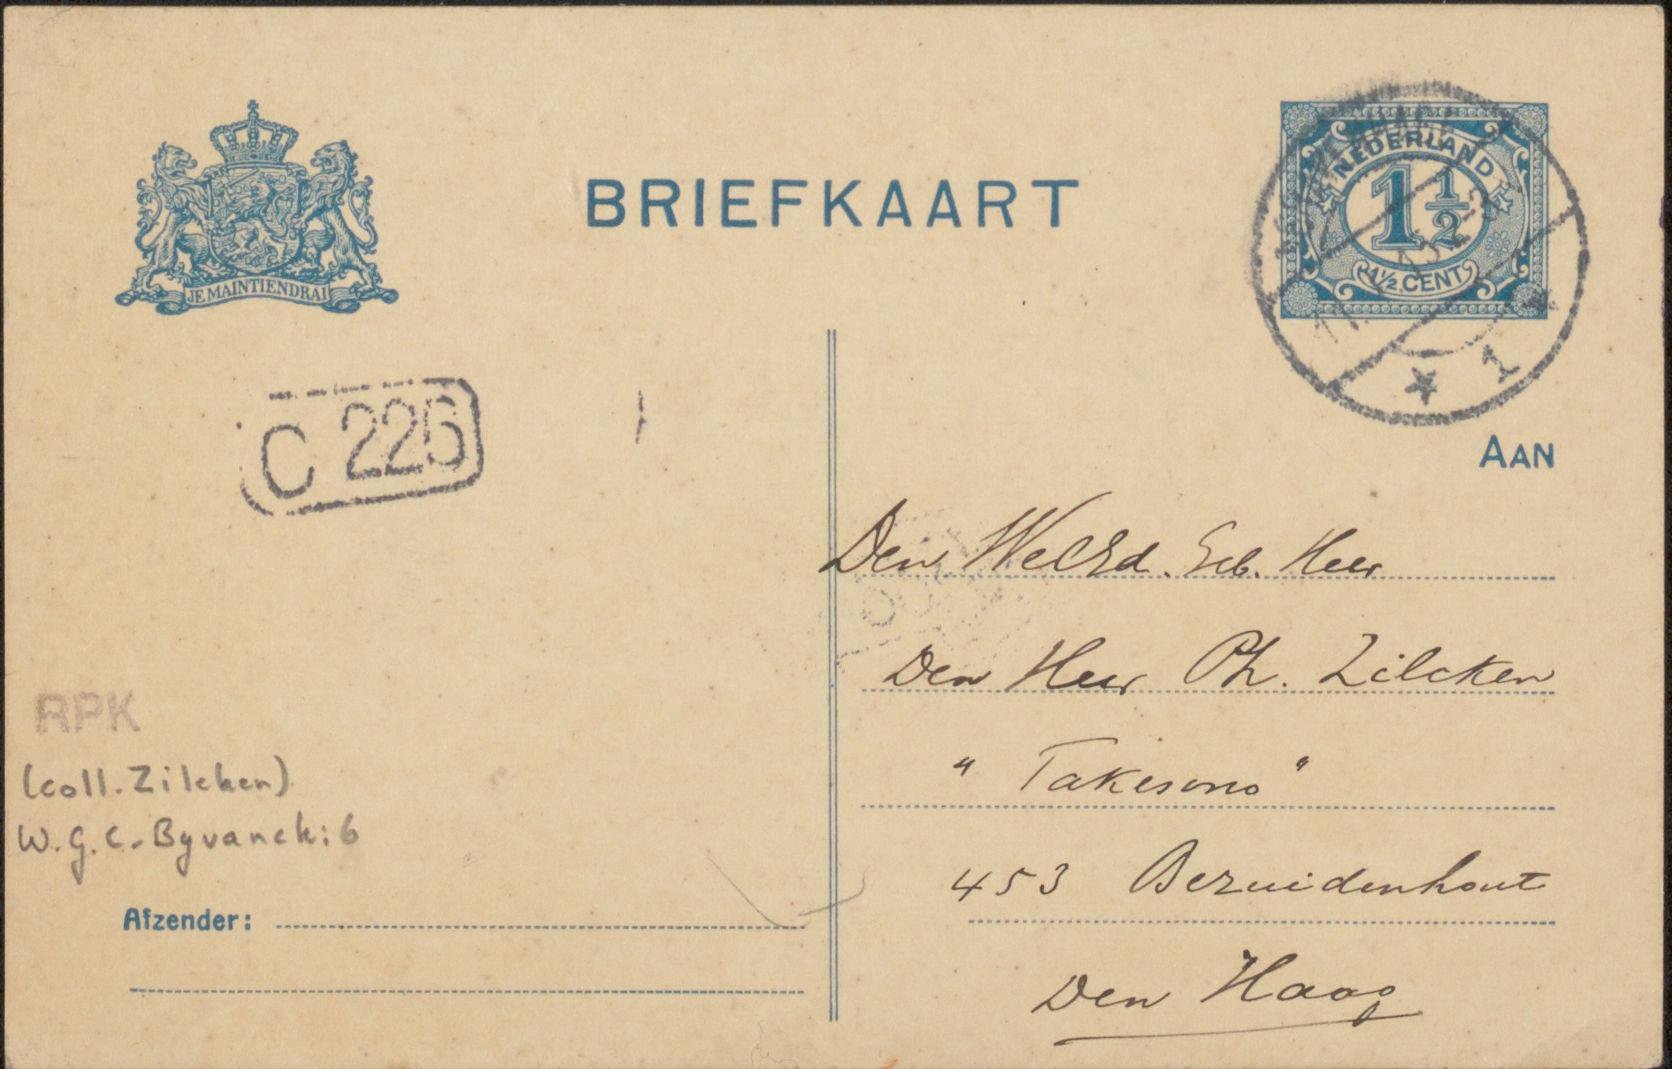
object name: postcard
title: Briefkaart aan Philip Zilcken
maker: willem byvanck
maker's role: bibliothecaris, schrijver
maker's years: 1848-1925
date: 1915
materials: cardboard, ink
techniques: pen, writing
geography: the hague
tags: painter, draughtsman, philip zilcken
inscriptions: collector's mark: ‘RPK’